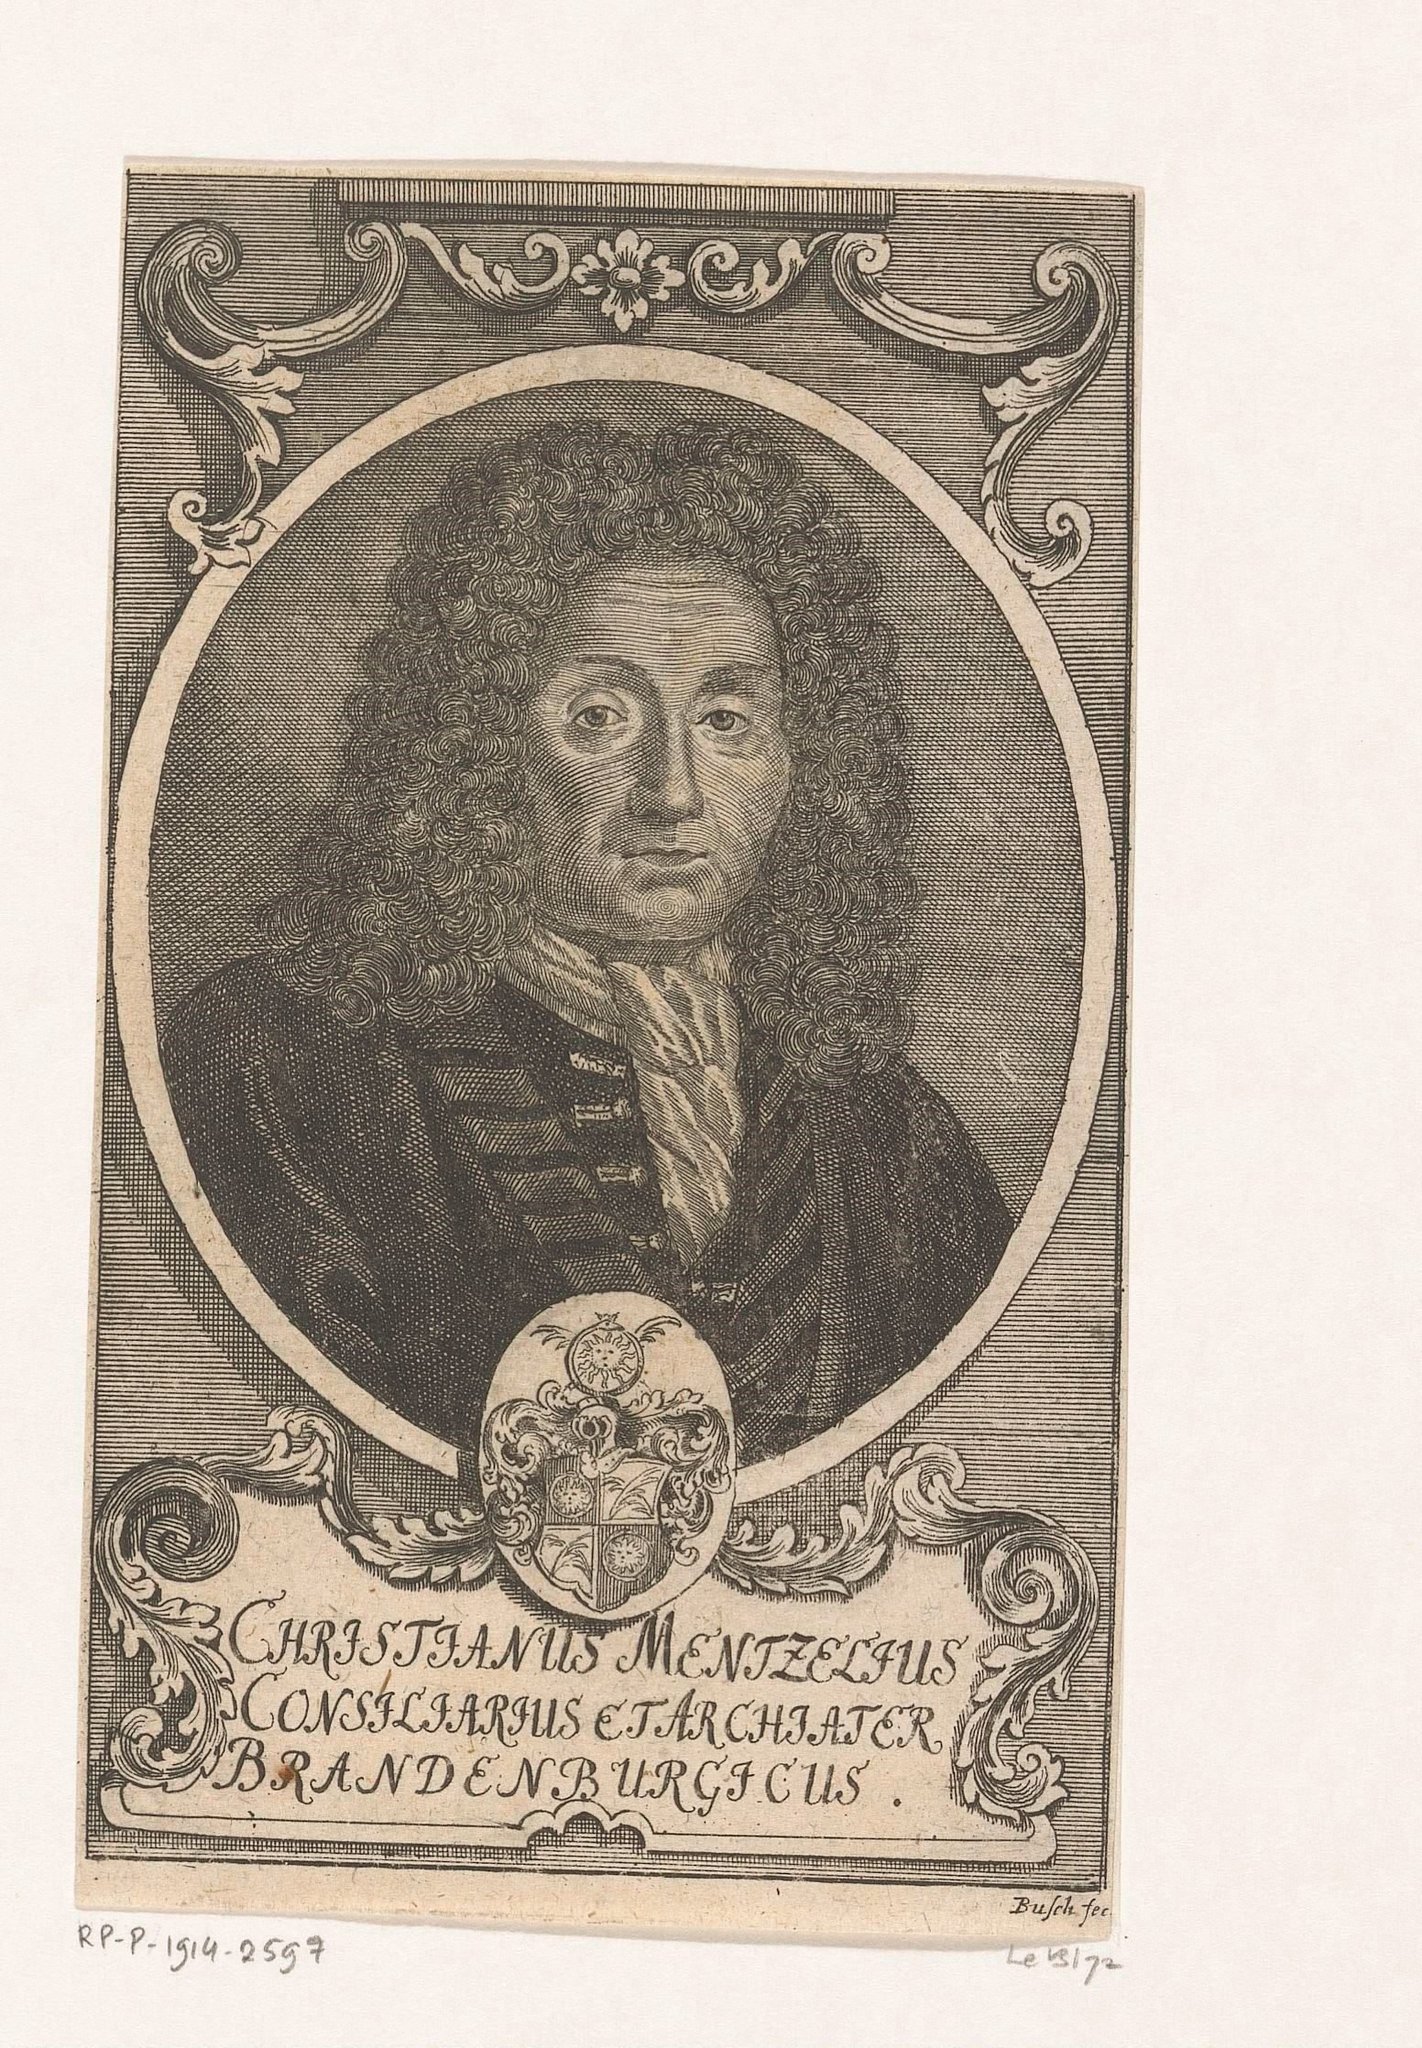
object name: book illustration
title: Portret van Christian Mentzel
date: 1724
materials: paper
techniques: engraving, etching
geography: berlin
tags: historical persons, armorial bearing, heraldry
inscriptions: collector's mark: Lugt 2228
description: Prent afkomstig uit: Acta Medicorum Berolinensium, in Incrementum Artis & Scientiarum collecta & digesta. Volumen IV. Berlijn: Gottfried Gedicke, 1724.